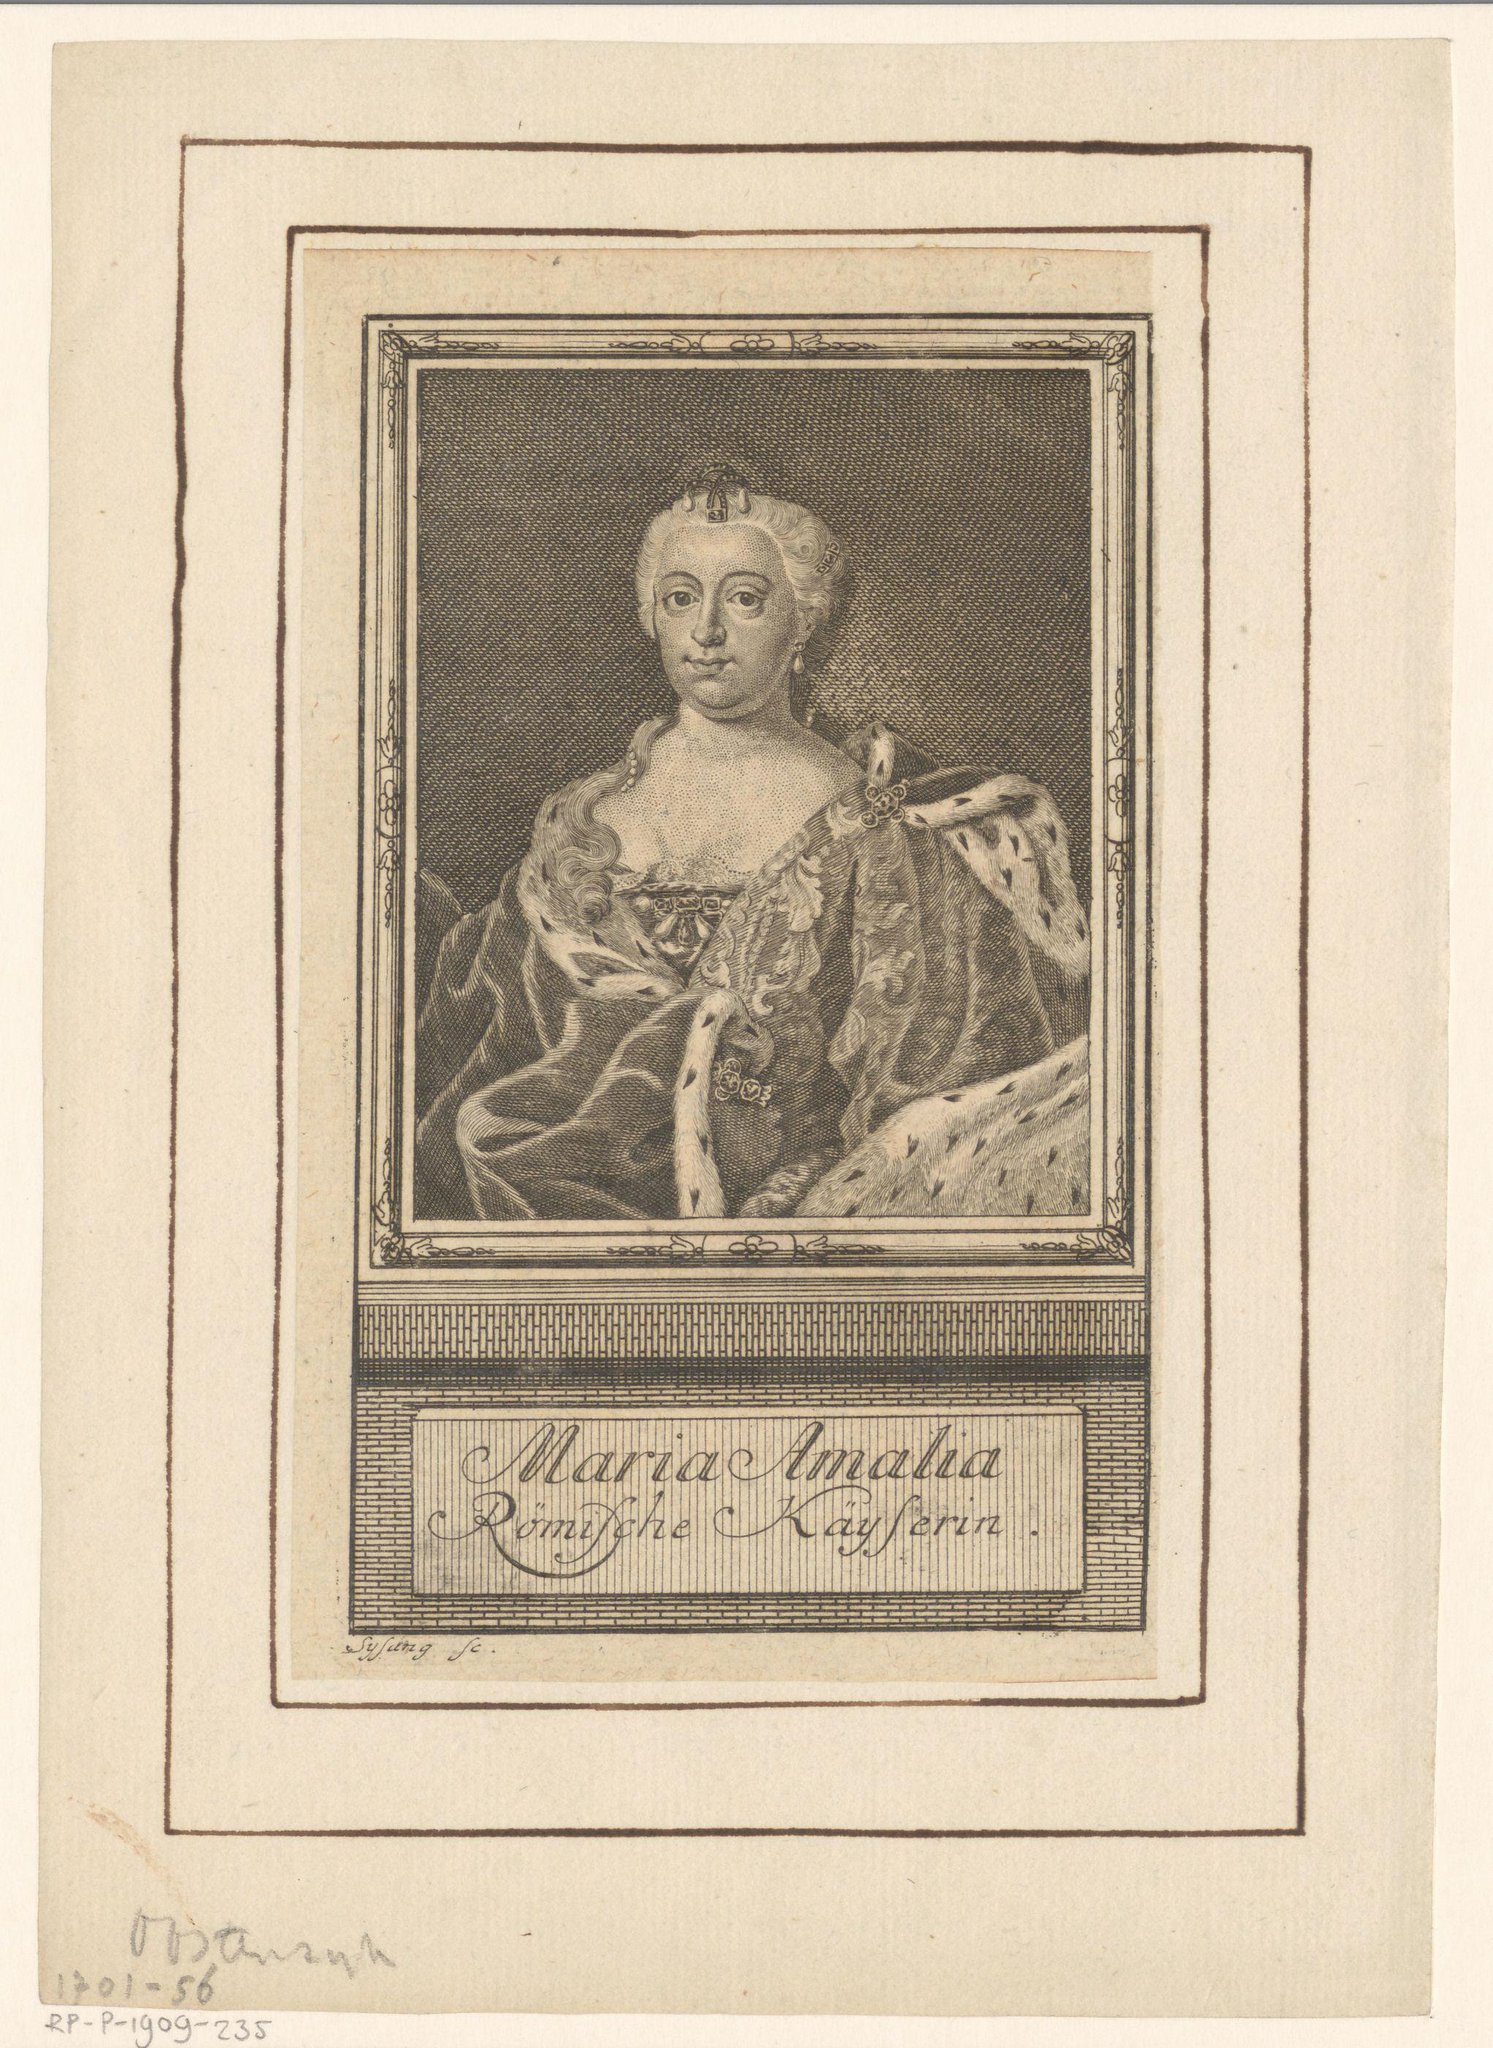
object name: print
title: Portret van Maria Amalia van Oostenrijk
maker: johann christoph sysang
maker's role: print maker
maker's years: 1703-1757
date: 1742-1757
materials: paper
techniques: engraving, etching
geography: leipzig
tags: vienna, historical persons - bb - woman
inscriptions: collector's mark: Lugt 2228